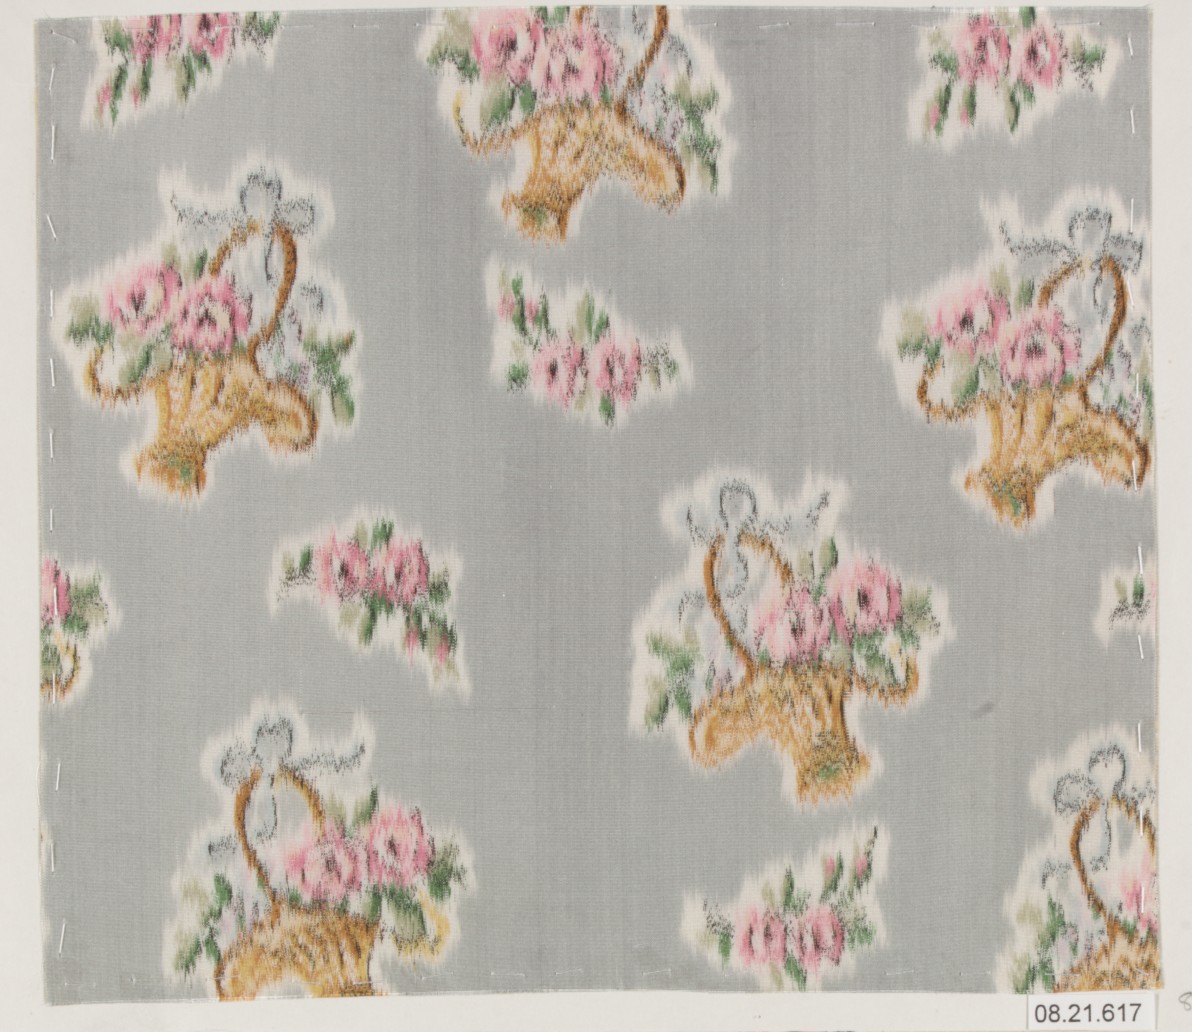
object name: textile sample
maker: Anonymous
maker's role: designer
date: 1900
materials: silk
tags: flowers